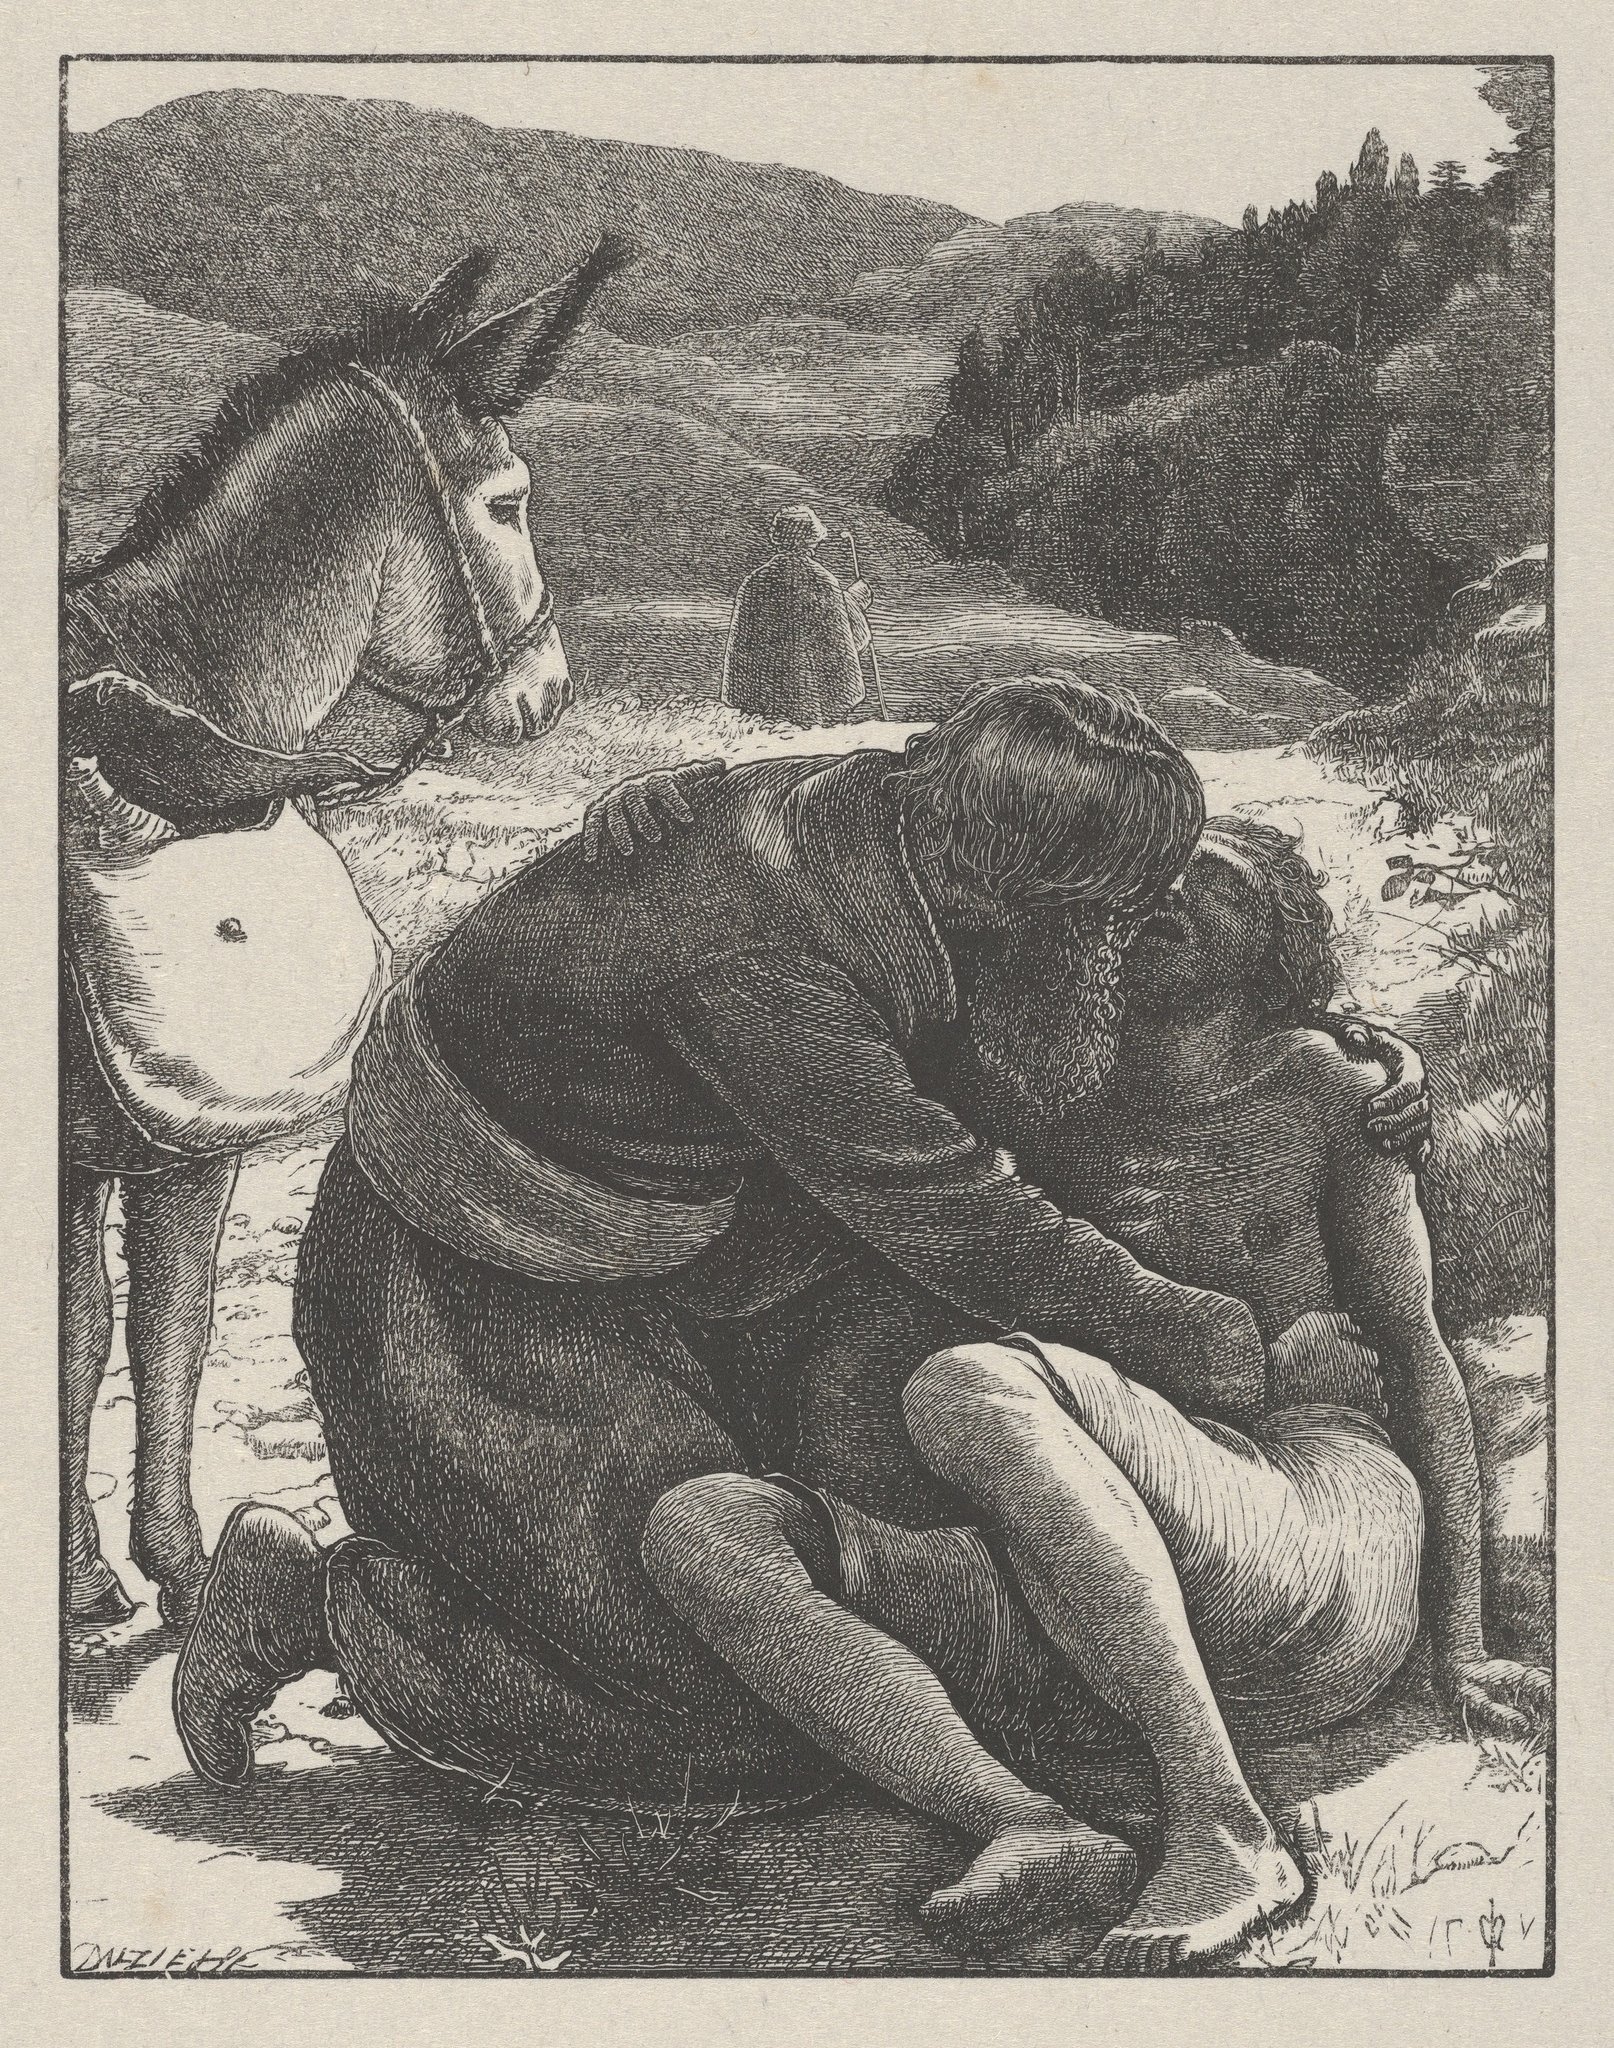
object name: print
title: The Good Samaritan (The Parables of Our Lord and Saviour Jesus Christ)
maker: sir john everett millais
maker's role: artist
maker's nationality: british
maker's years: 1829-1896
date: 1864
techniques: engraving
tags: suffering,men,donkeys,landscapes